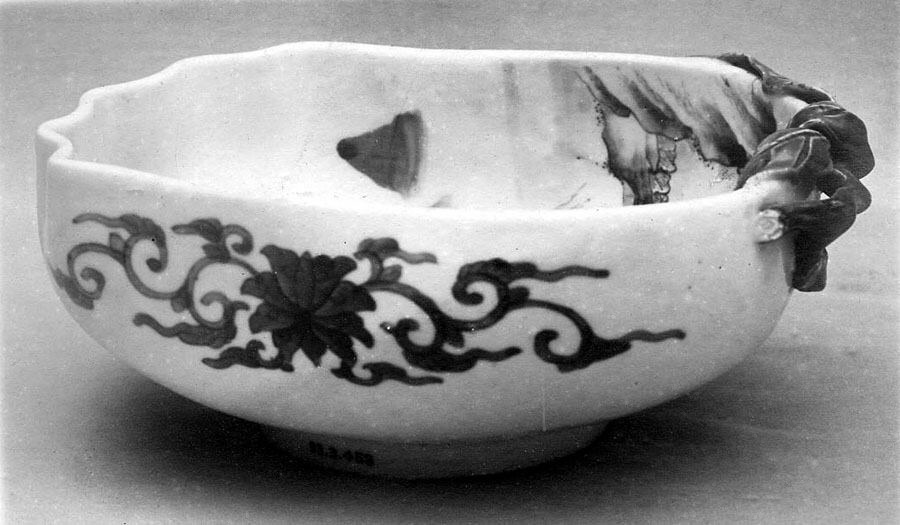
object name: bowl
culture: japanese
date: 1820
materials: glaze, porcelain